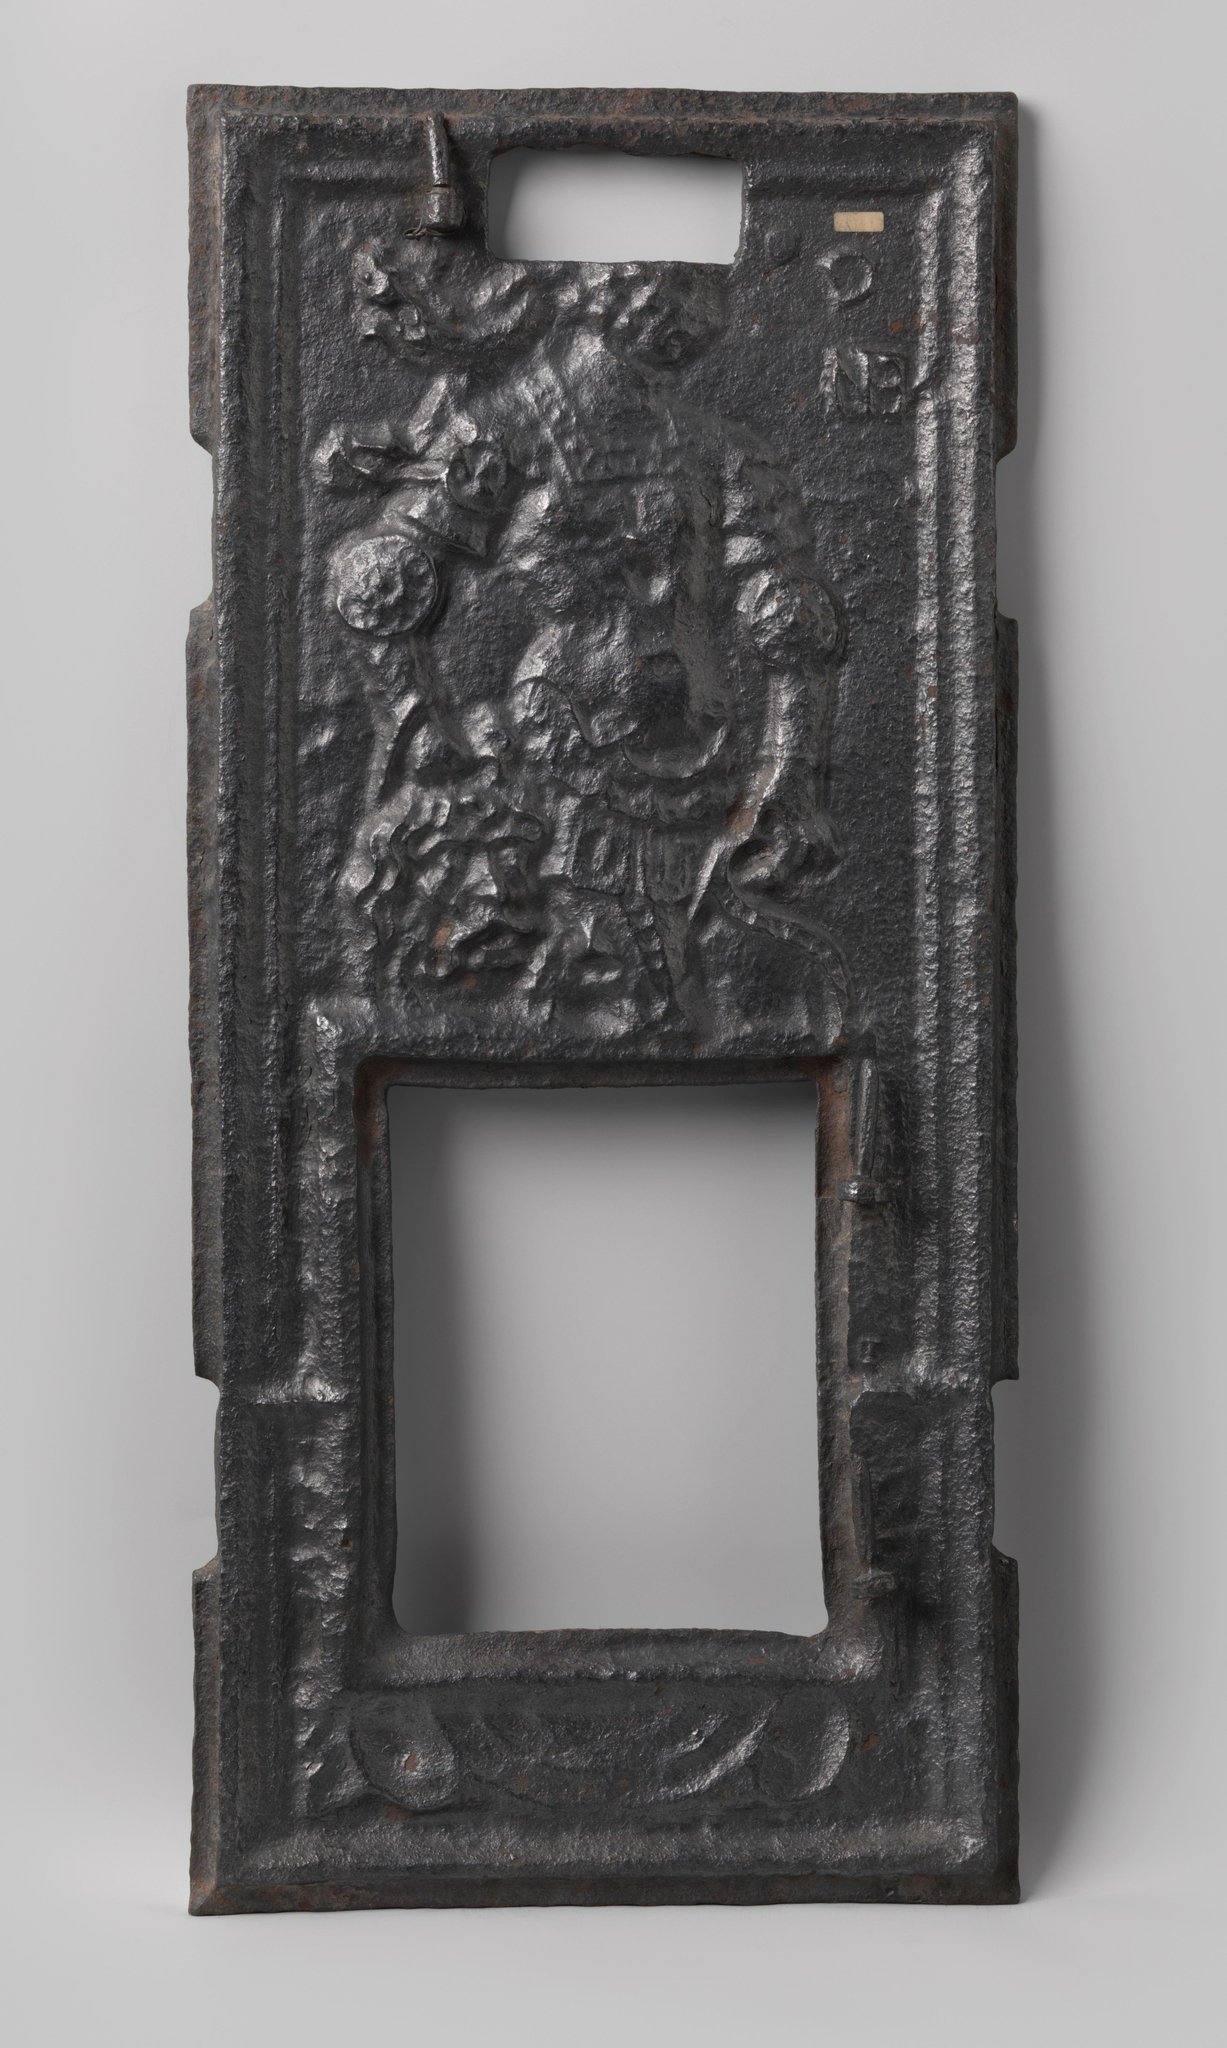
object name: stove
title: Kachelplaat met koning David met het hoofd van Goliath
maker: Anonymous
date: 1660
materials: iron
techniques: casting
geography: germany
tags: david with goliath's head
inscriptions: maker's mark: ‘G / NB’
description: Kachelplaat van gietijzer, verdeeld in twee zones. Centraal in de bovenste zone staat koning David, naar rechts lopend, met in zijn rechterhand het hooft van Goliath en in zijn linkerhand een harp. De onderste zone heeft een gezicht in een medaillon omringd door ranken. Gemerkt: naast het hoofd van David de initialen G / NB en onder de voeten van David het jaartal 1660. De plaat heeft in de onderste helft en helemaal bovenaan een opening, waarvoor een deurtje is gehangen kan worden met behulp van twee scharnieren.